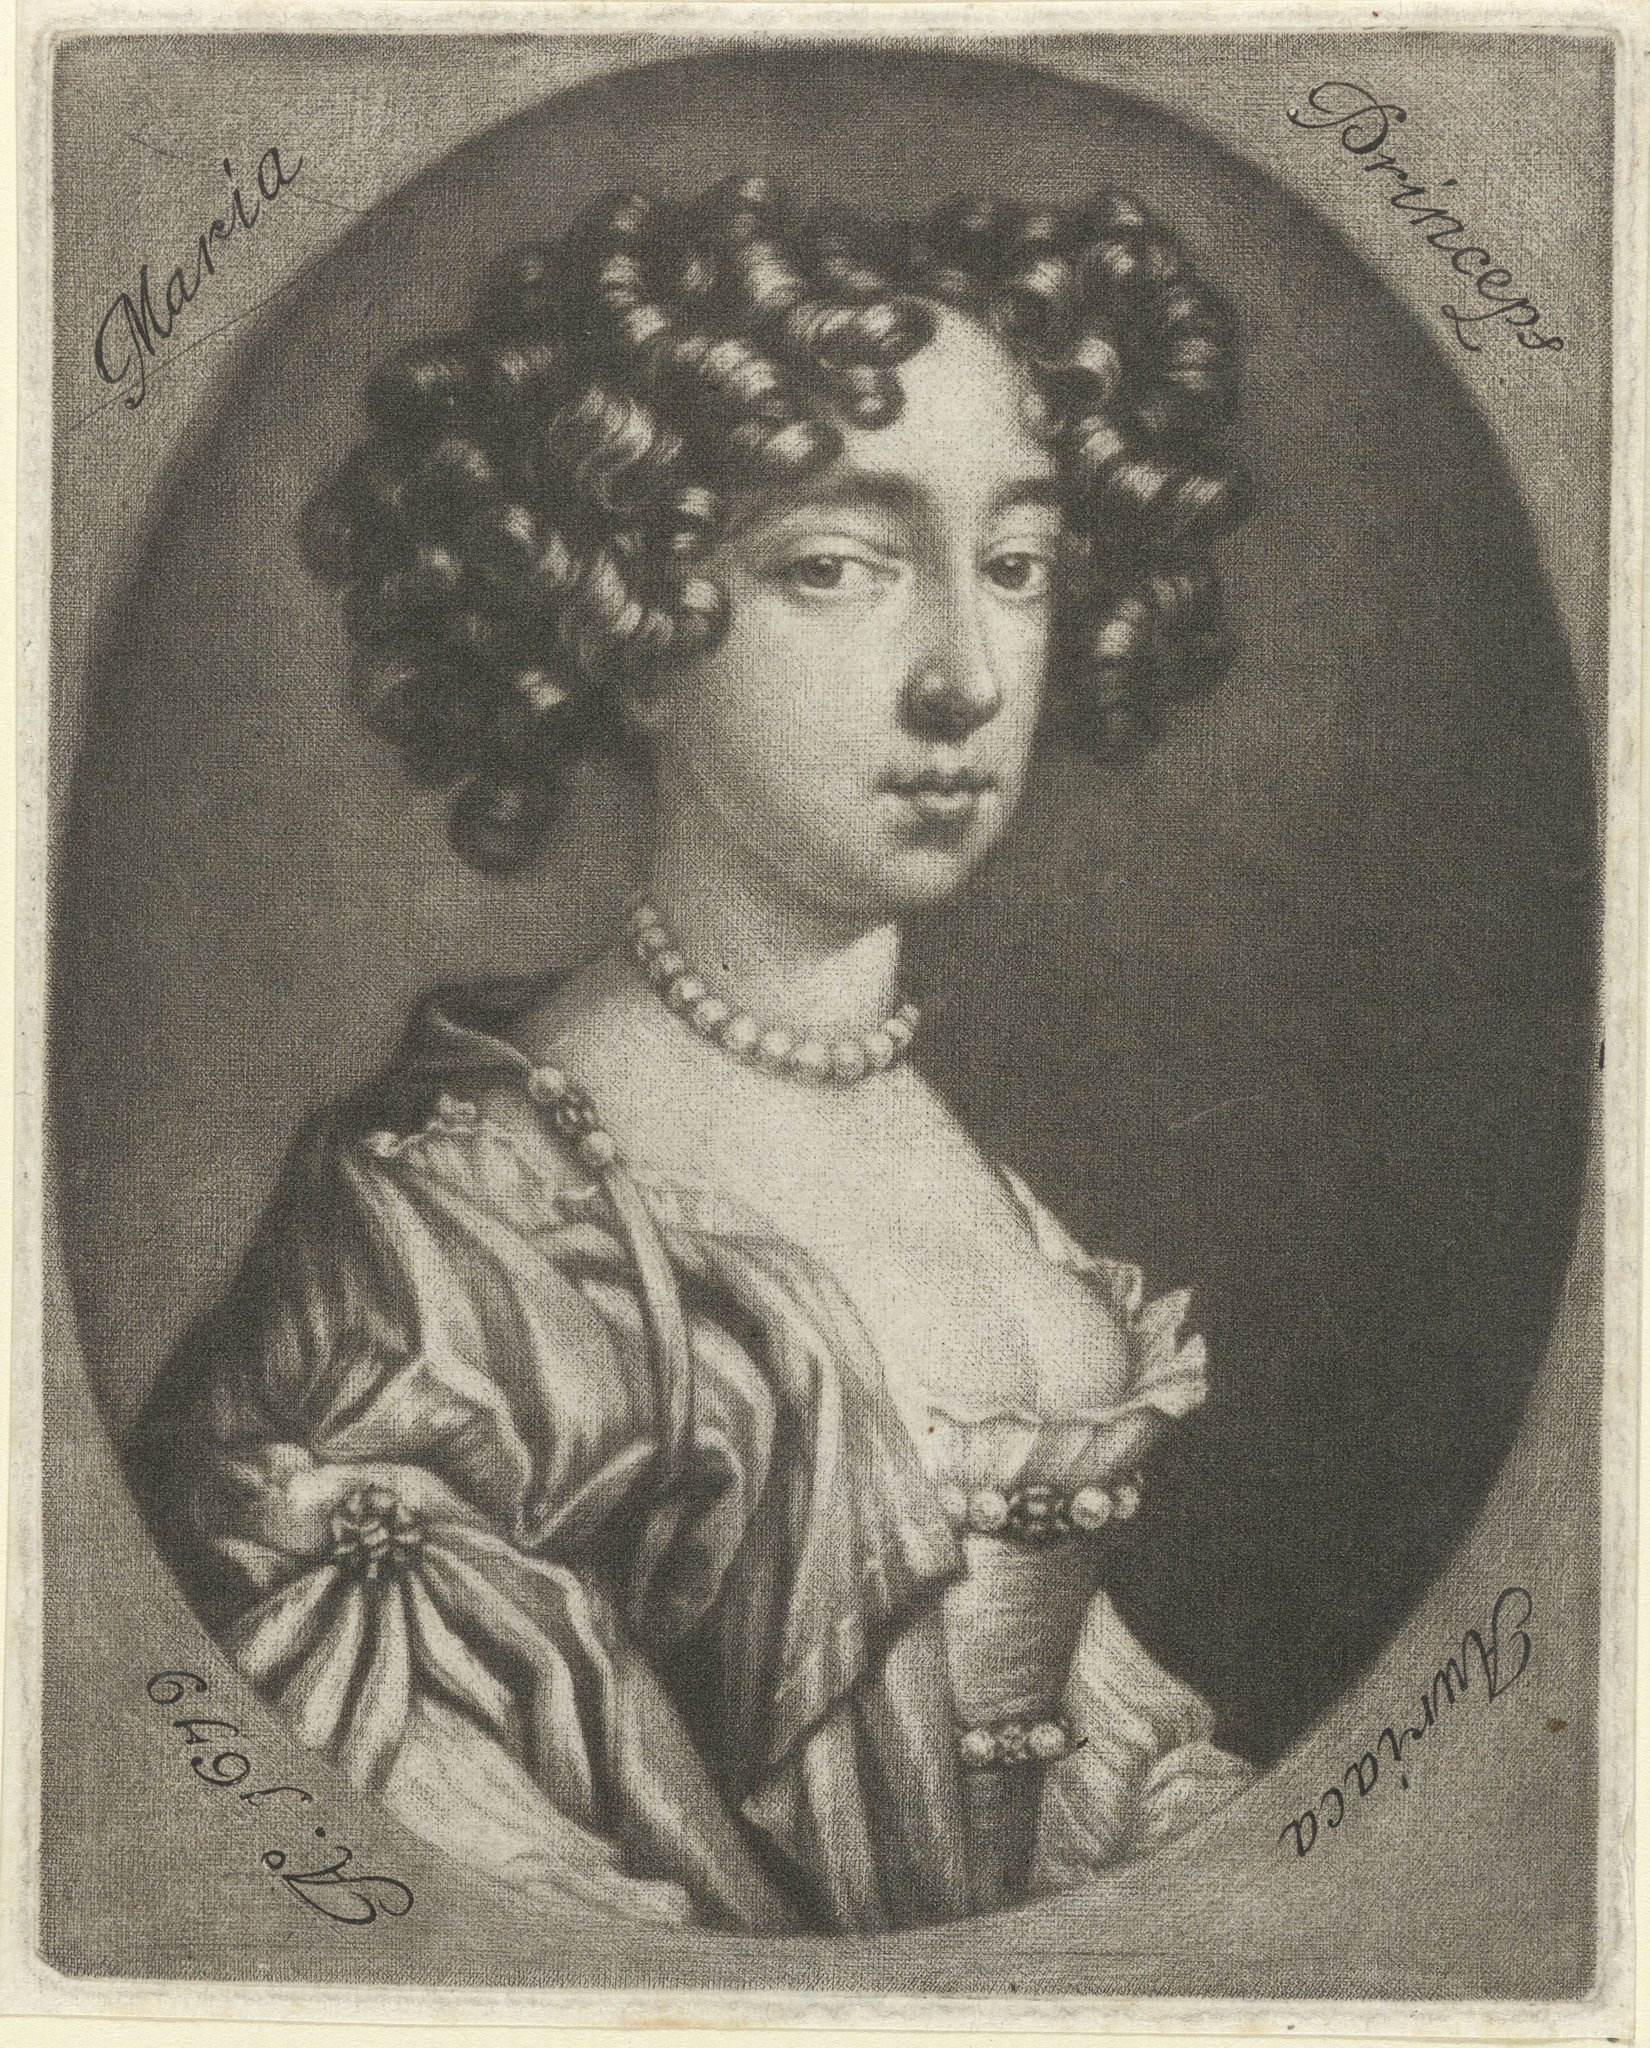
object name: print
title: Portret van Maria II Stuart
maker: Anonymous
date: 1679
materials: paper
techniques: mezzotint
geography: low countries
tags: london, maria ii stuart (koningin van engeland, schotland en ierland)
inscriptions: collector's mark: Lugt 963, collector's mark: Lugt 2228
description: Portret van Maria II in een ovaal met randschrift.